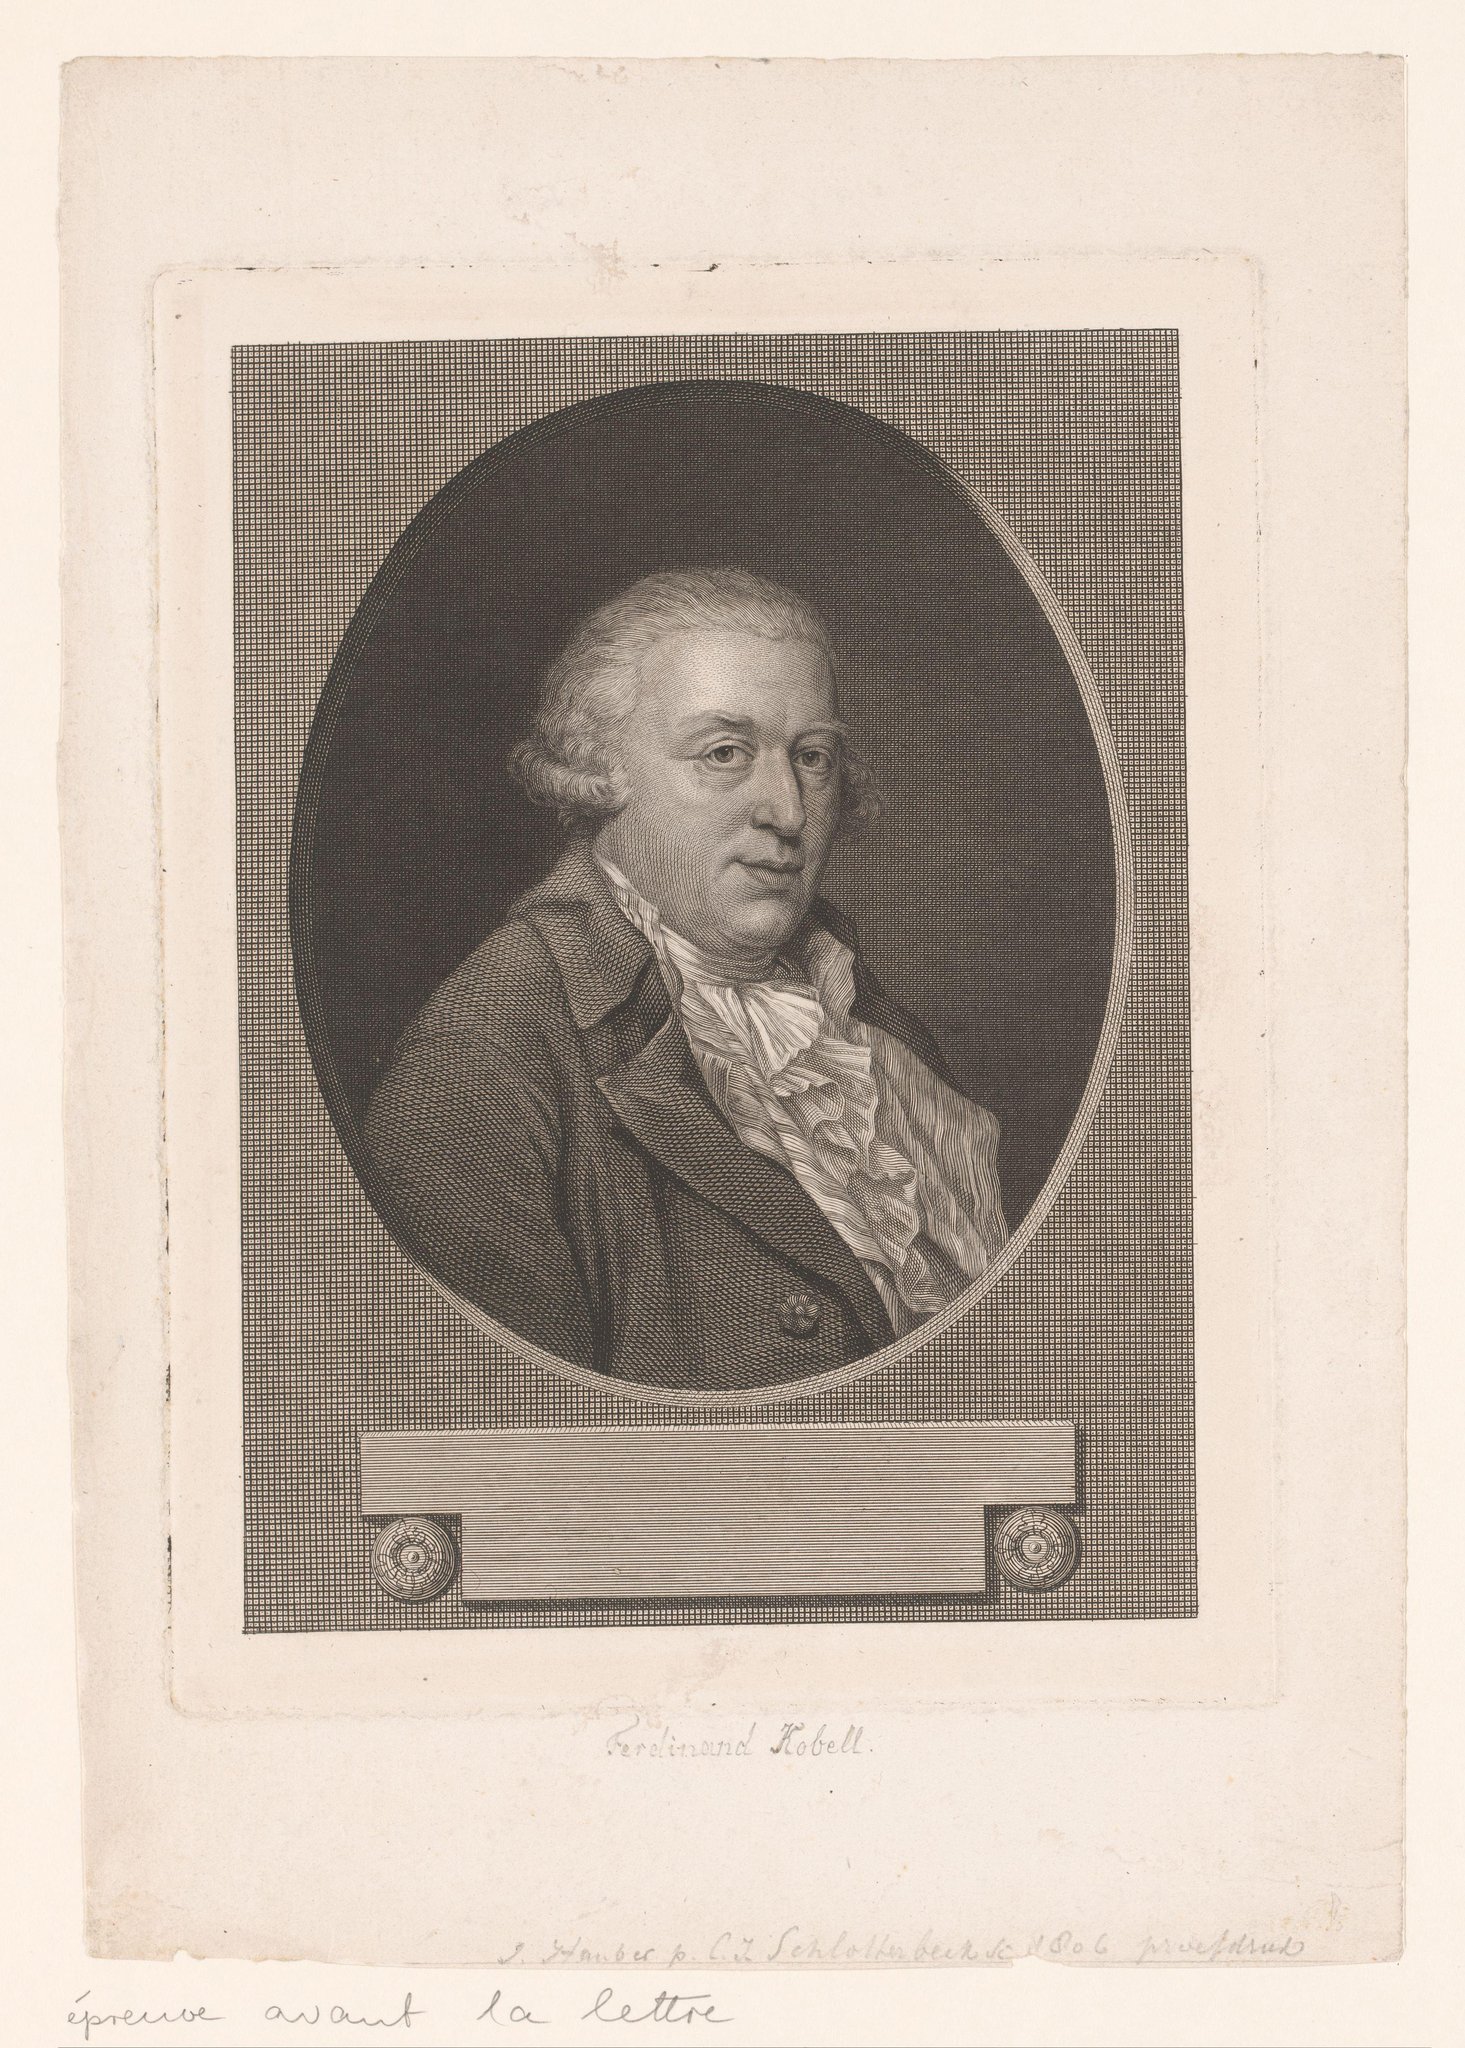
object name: print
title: Portret van Ferdinand Kobell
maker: christian jakob schlotterbeck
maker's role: print maker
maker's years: 1757-1812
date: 1767-1811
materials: paper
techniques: engraving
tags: painter, artist, ferdinand kobell, historical persons, portrait, self-portrait of draughtsman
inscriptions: collector's mark: Lugt 2228